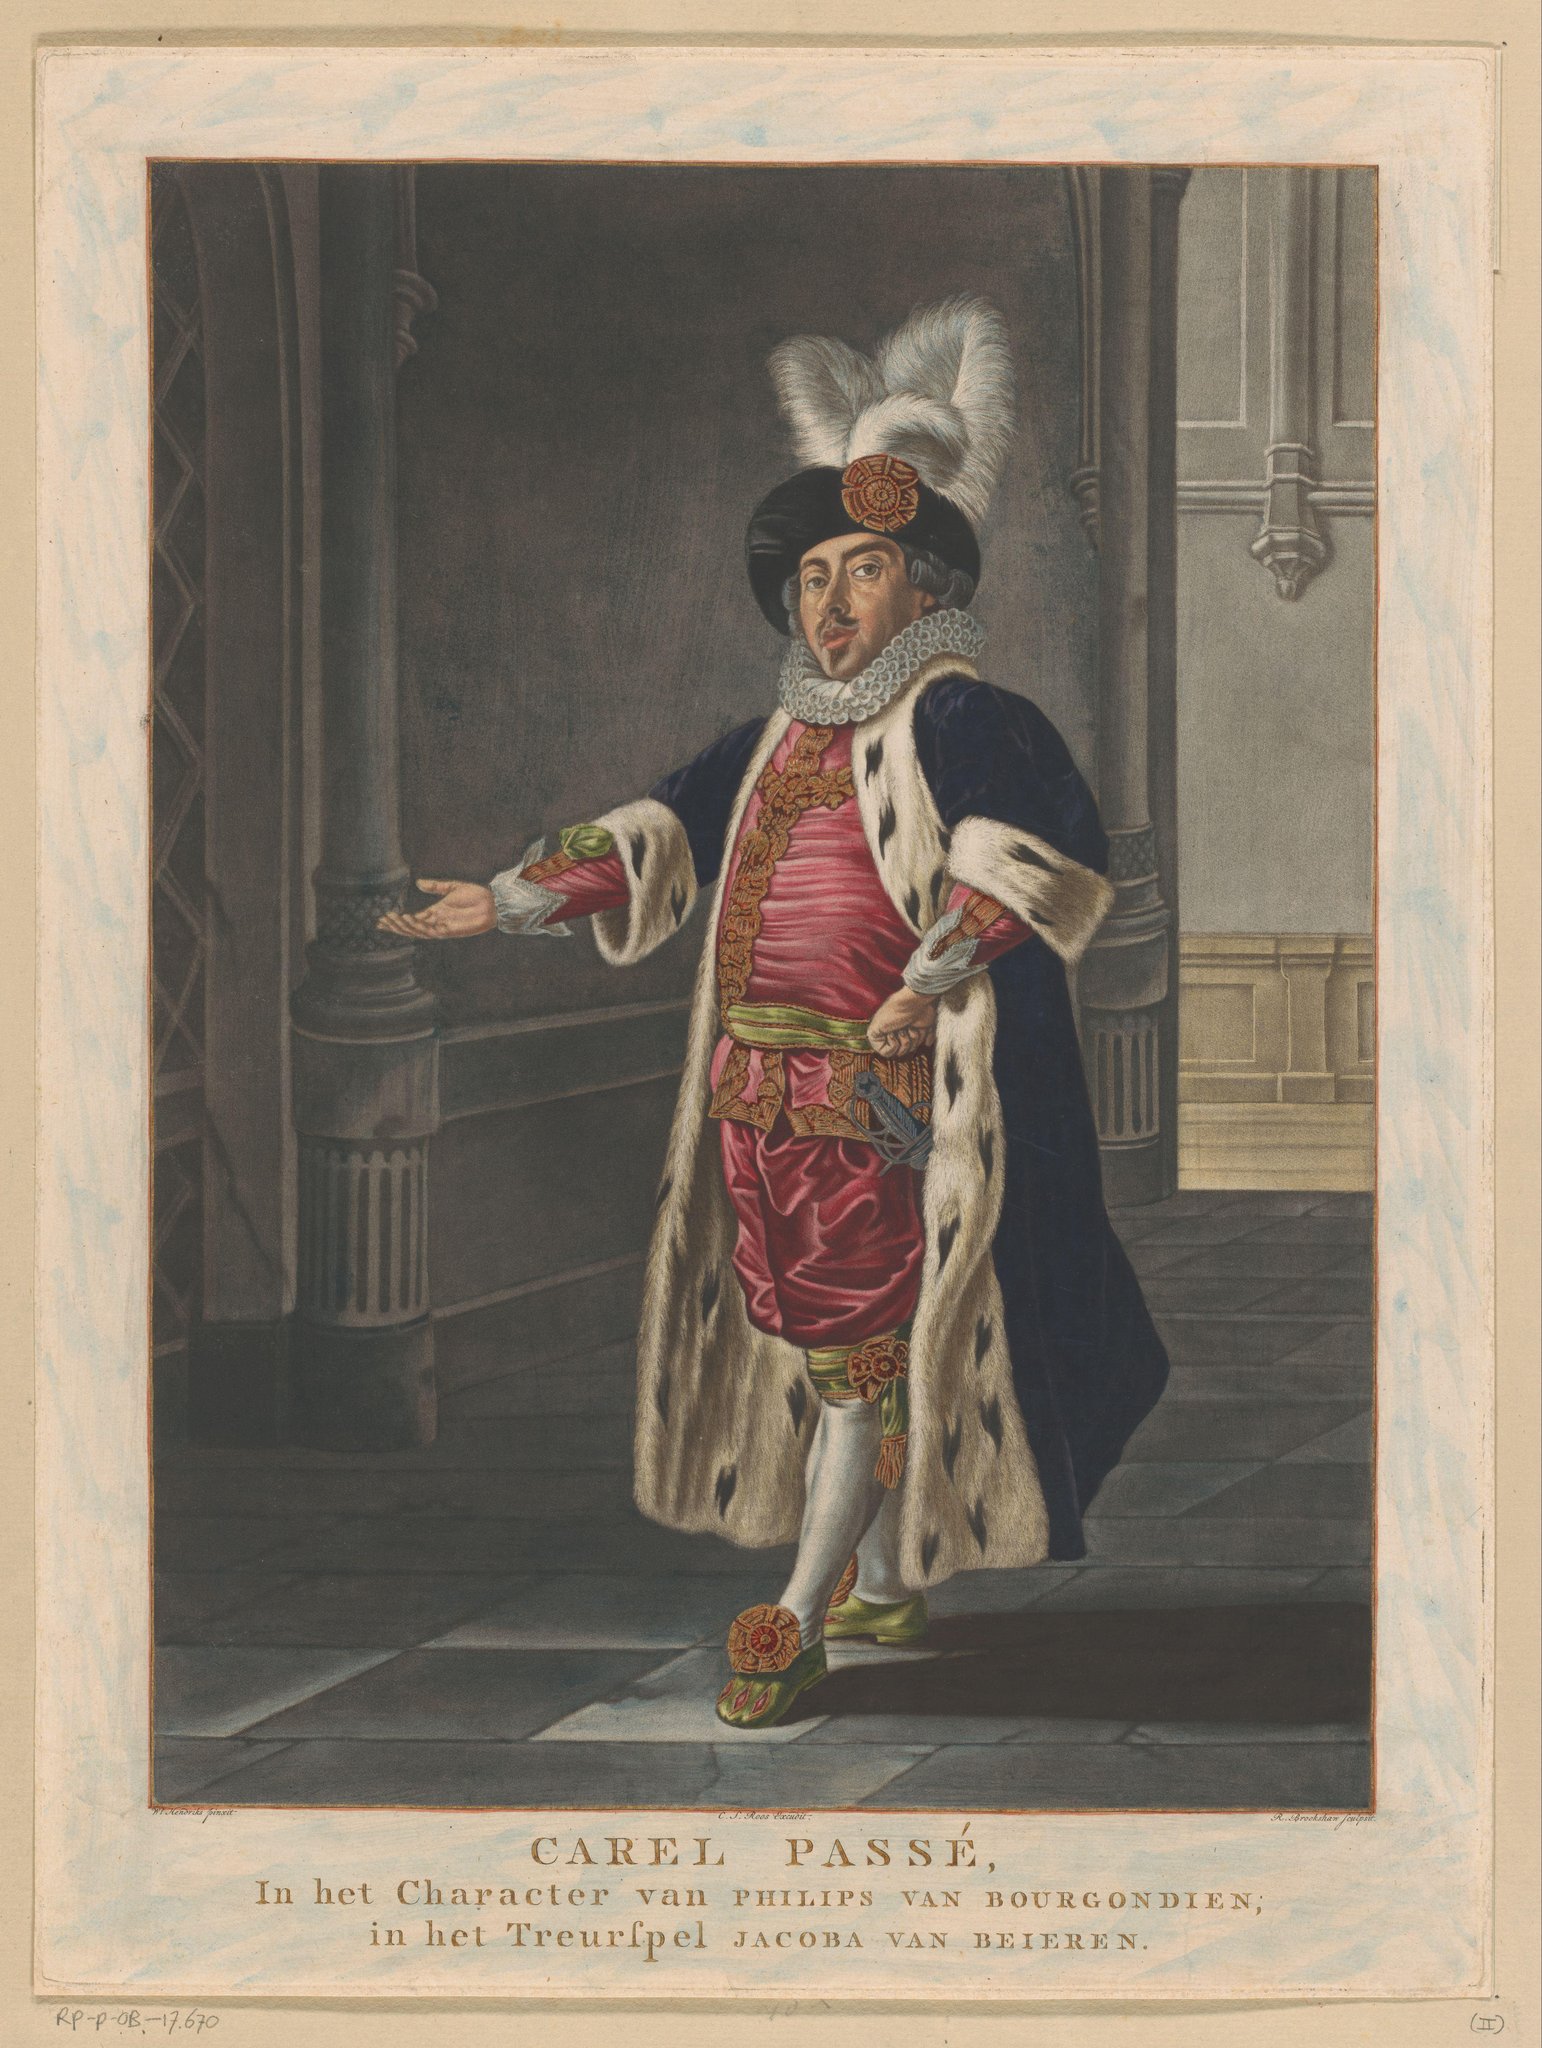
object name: print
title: Carel Passé, in het Character van Philips van Bourgondien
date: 1779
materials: paper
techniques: hand coloring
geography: amsterdam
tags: philip iii the good, historical persons, portrait of actor, actress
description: Passé als Filips de Goede in het treurspel Jacoba van Beieren.